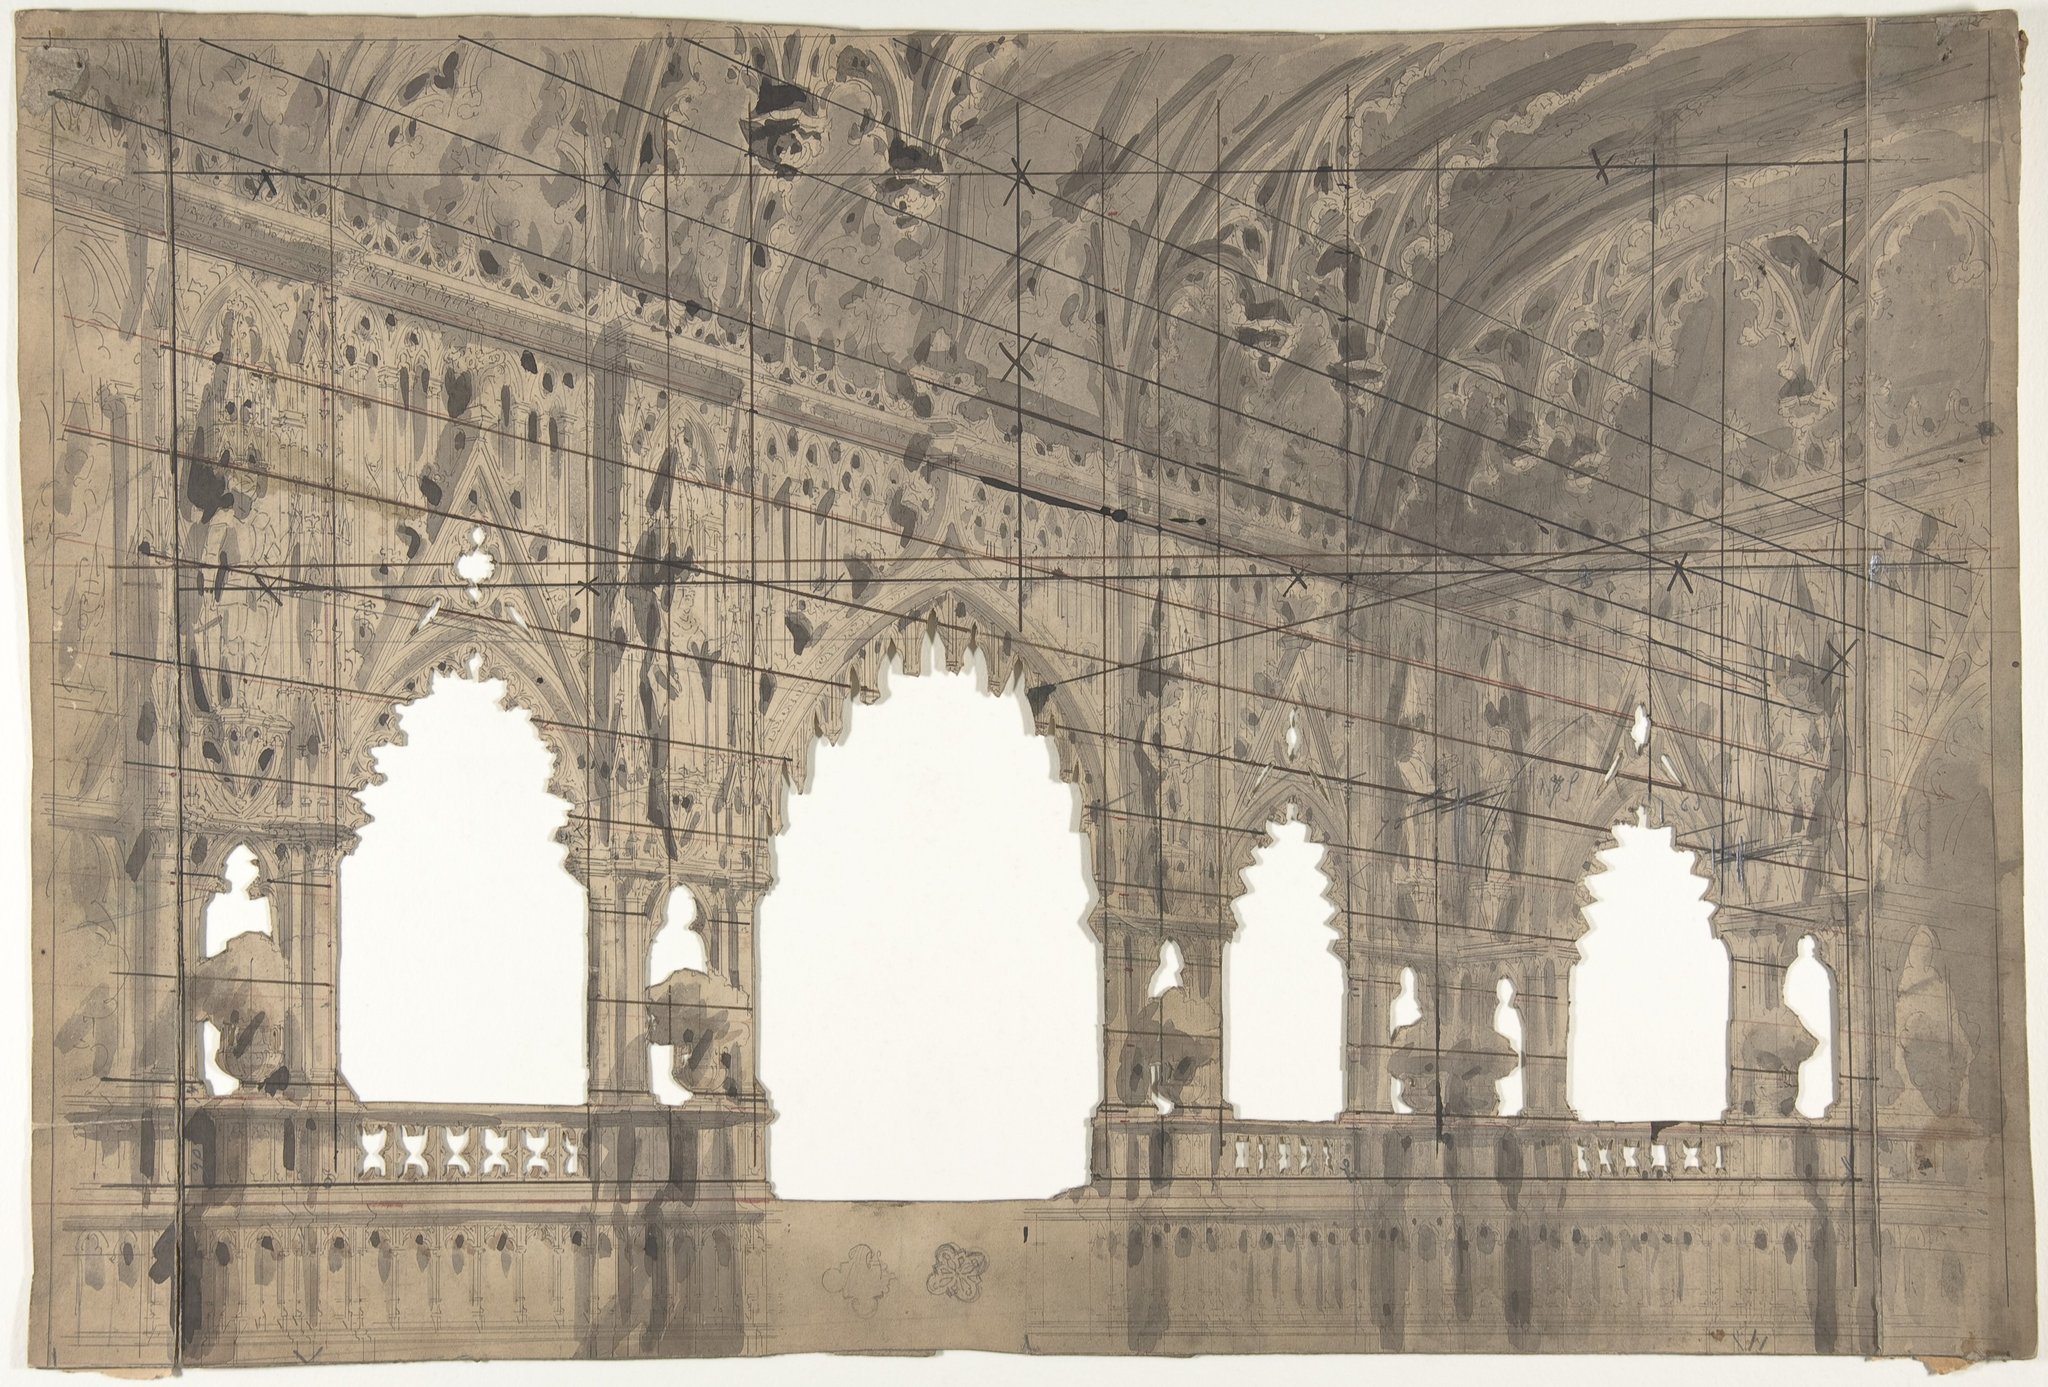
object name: drawing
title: Design for a Stage Set at the Opéra, Paris: Church Interior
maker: eugène cicéri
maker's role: artist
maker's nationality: french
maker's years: 1813-1890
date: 1830-1890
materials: graphite, ink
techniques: brush, pen, wash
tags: churches,stage design